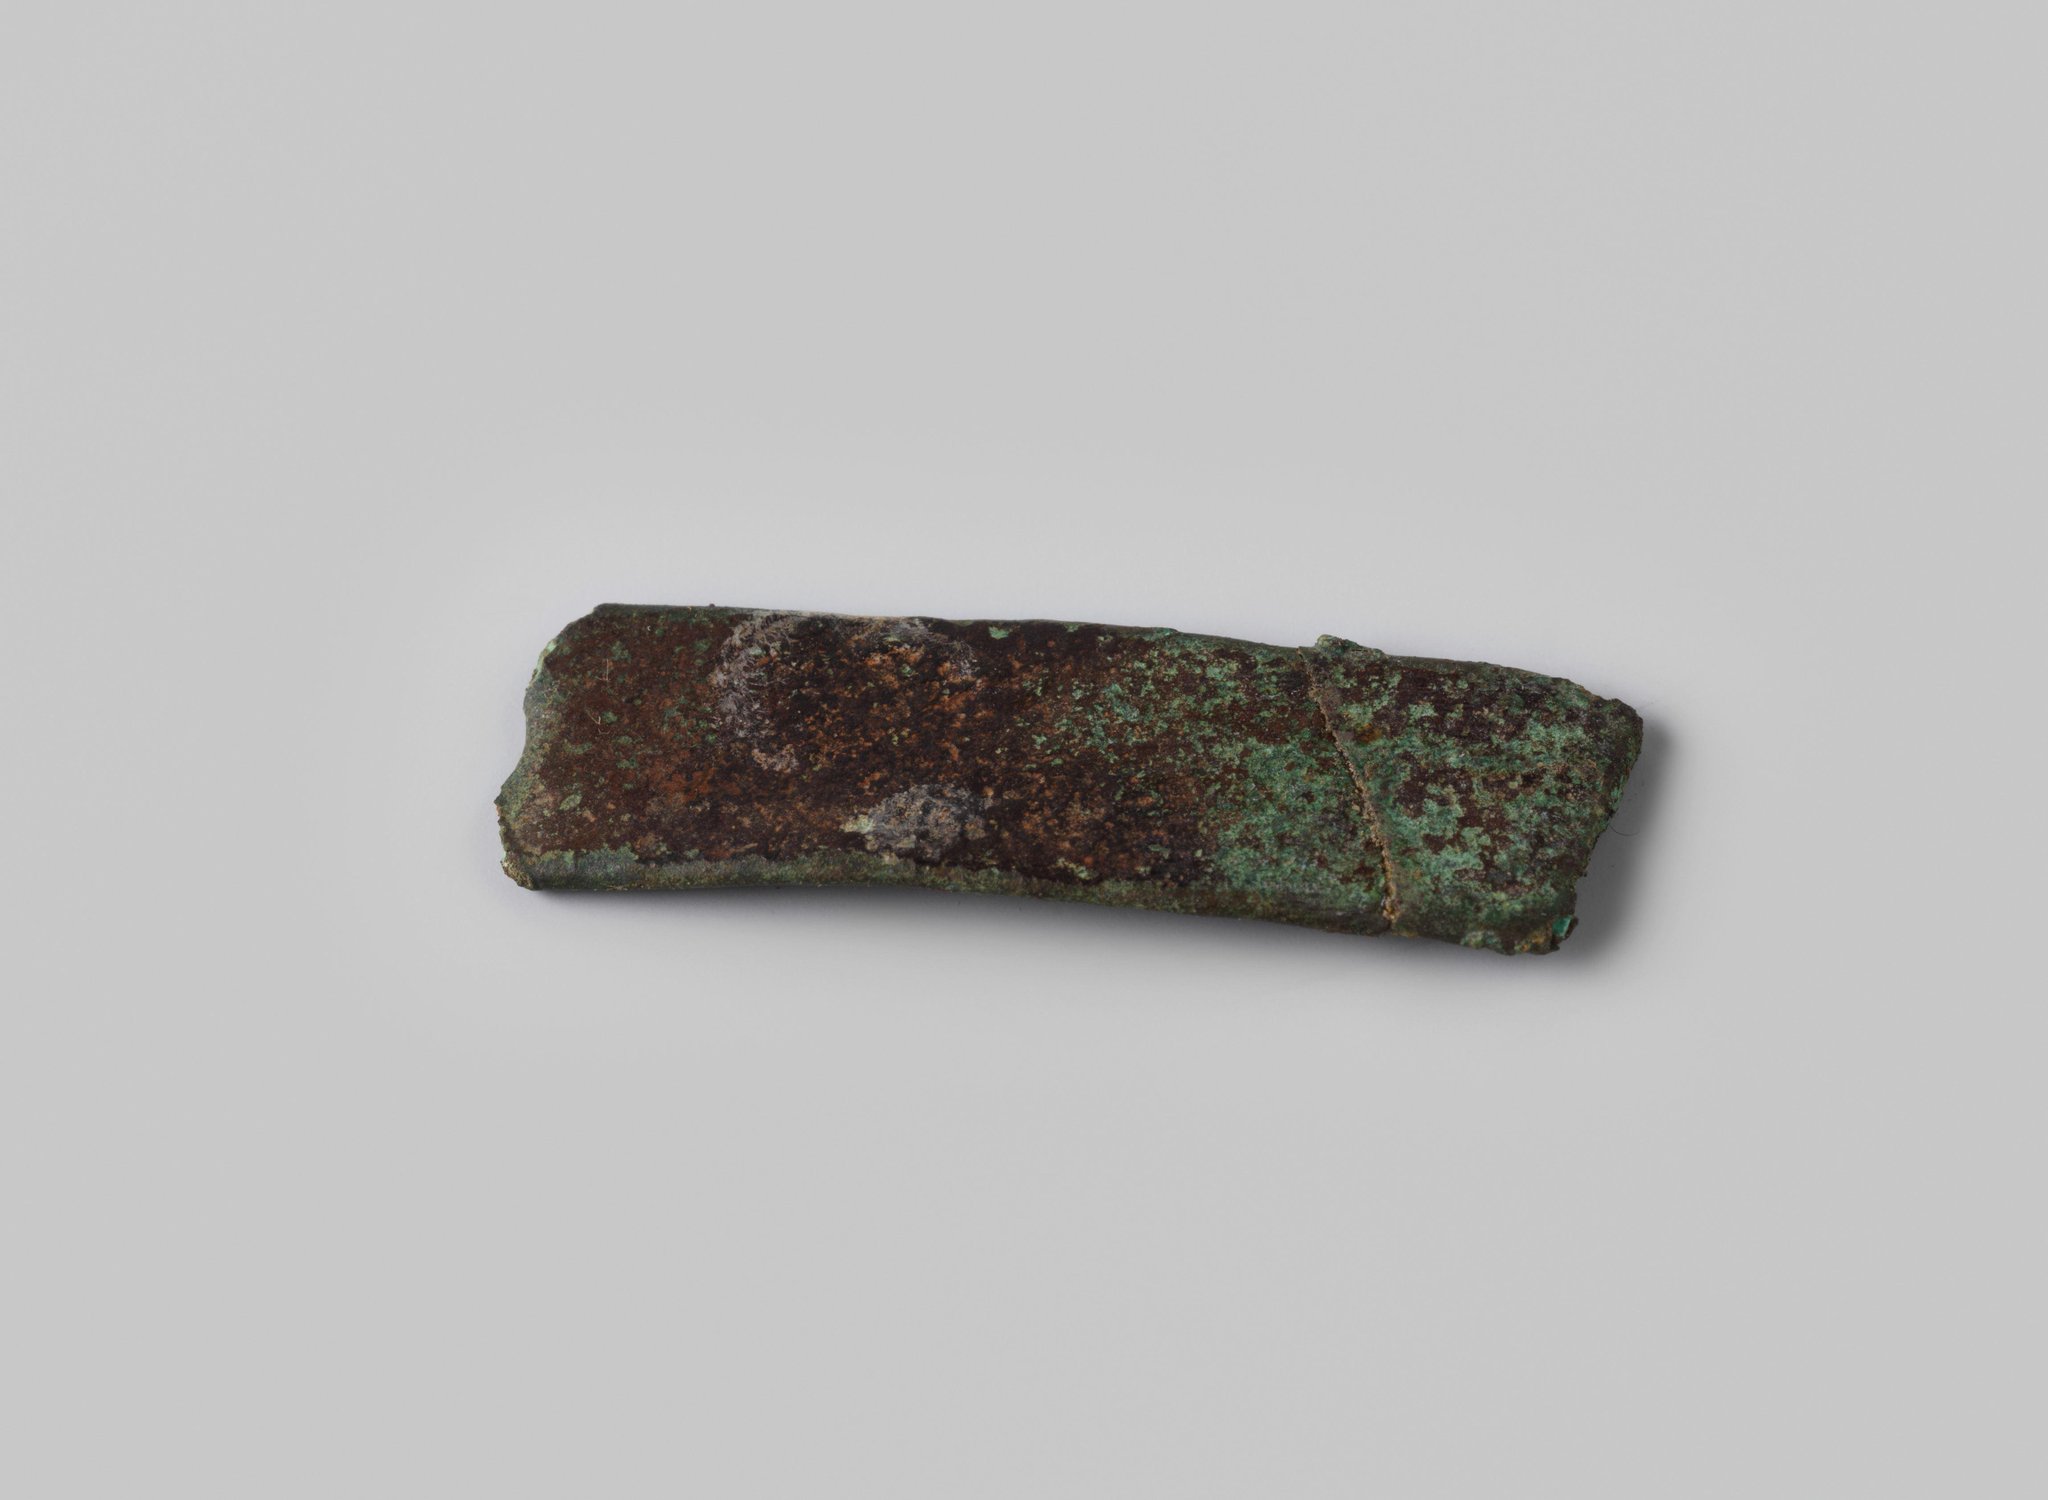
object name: fragment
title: Fragment van koper uit het wrak van de Oost-Indiëvaarder Hollandia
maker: Anonymous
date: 1700-1743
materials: copper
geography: netherlands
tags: verenigde oostindische compagnie, hollandia (schip), annet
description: Varied parts or fragments, strips and strip-shaped fragments; fragm.